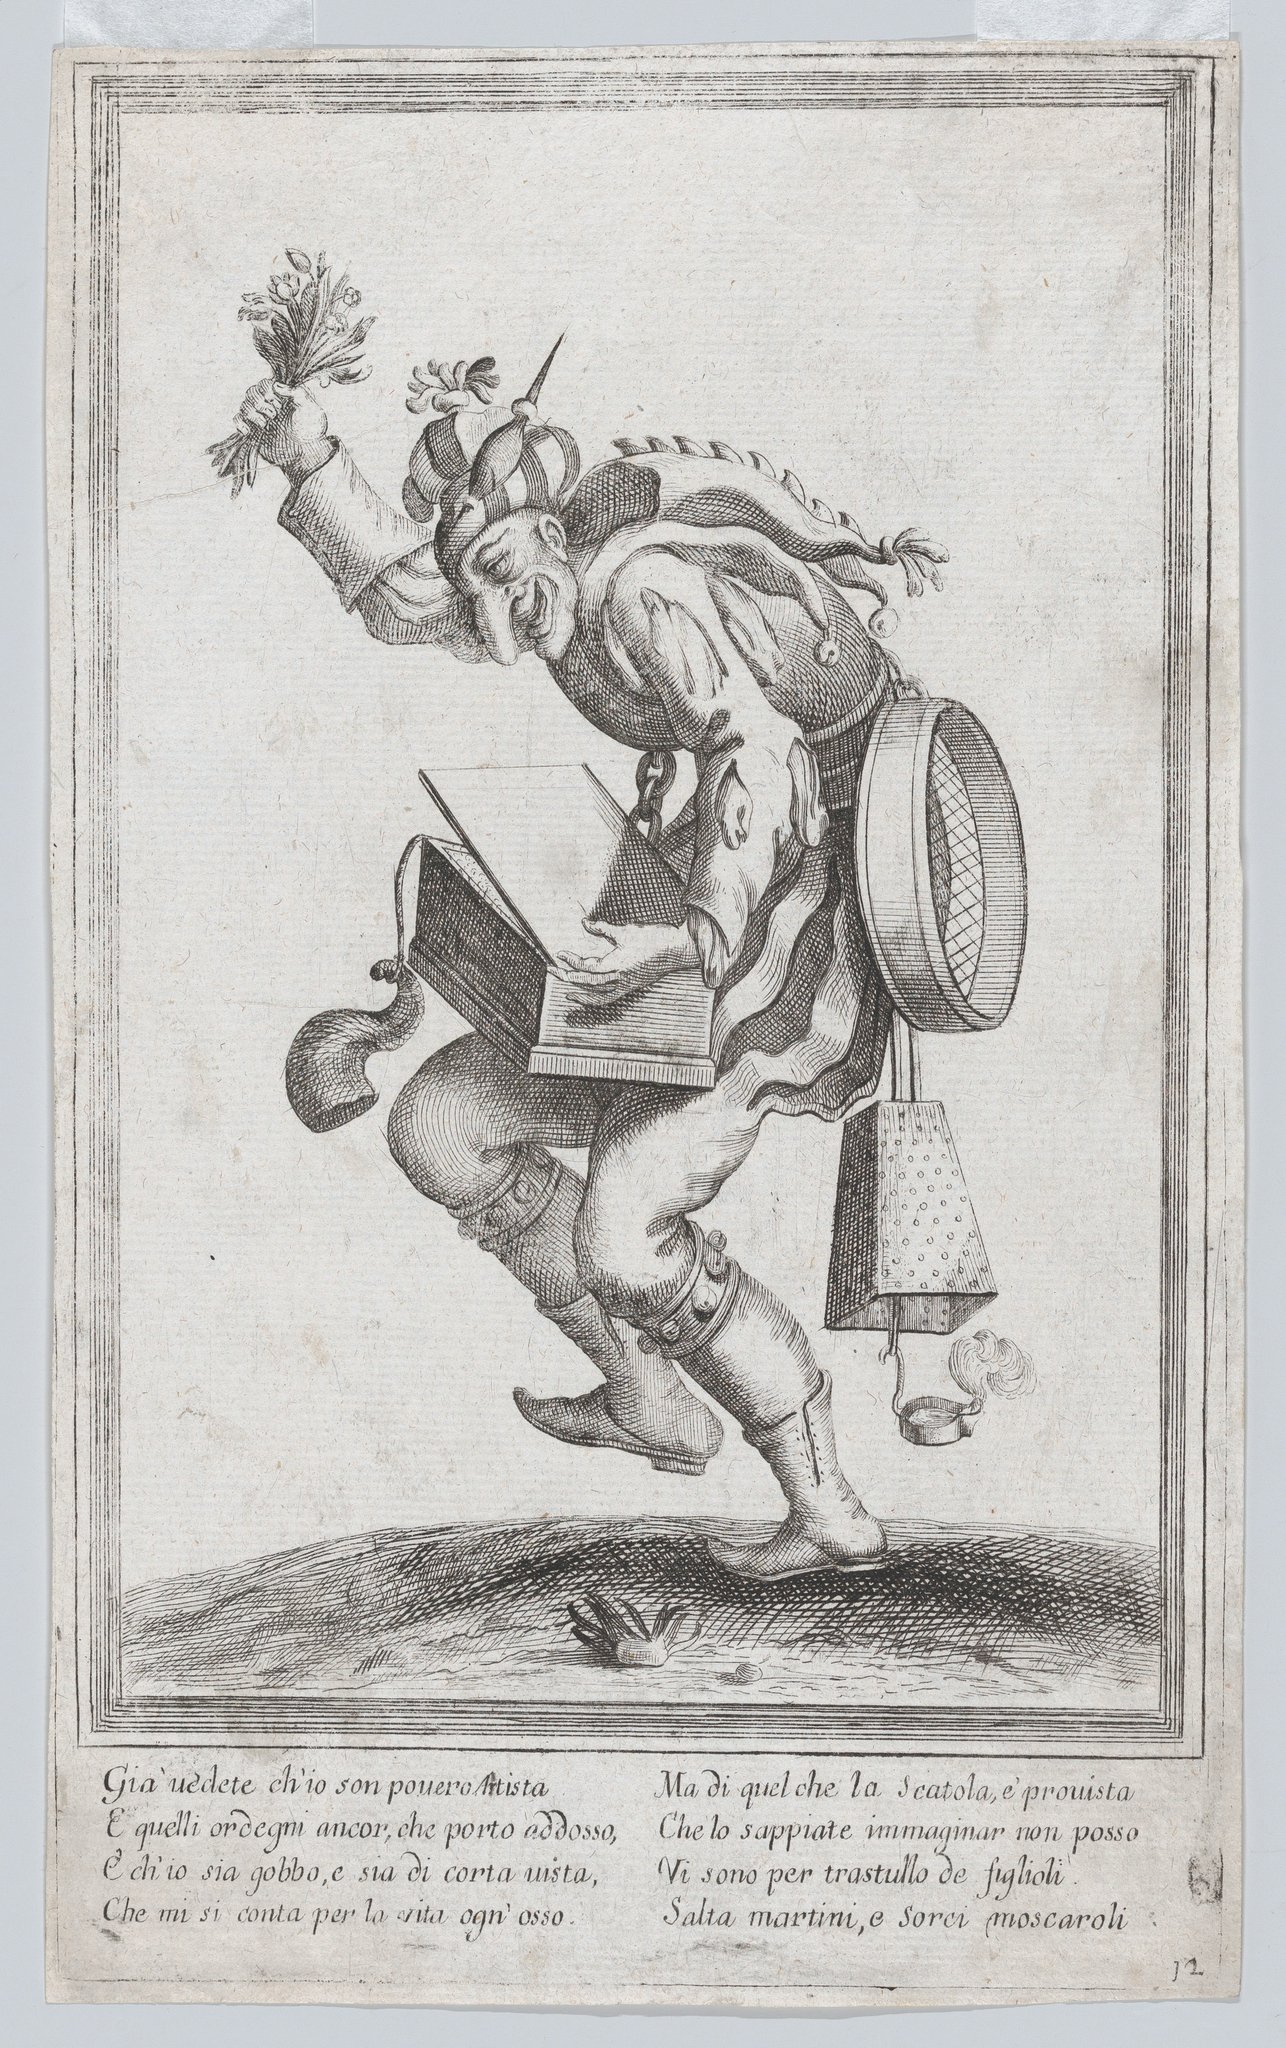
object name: print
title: A caricature figure representing a poor itinerant artist loaded with various implements relating to his trade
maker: anonymous, italian, 17th century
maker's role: artist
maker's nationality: italian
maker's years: 1600-1700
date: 1640-1660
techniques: engraving, etching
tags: men